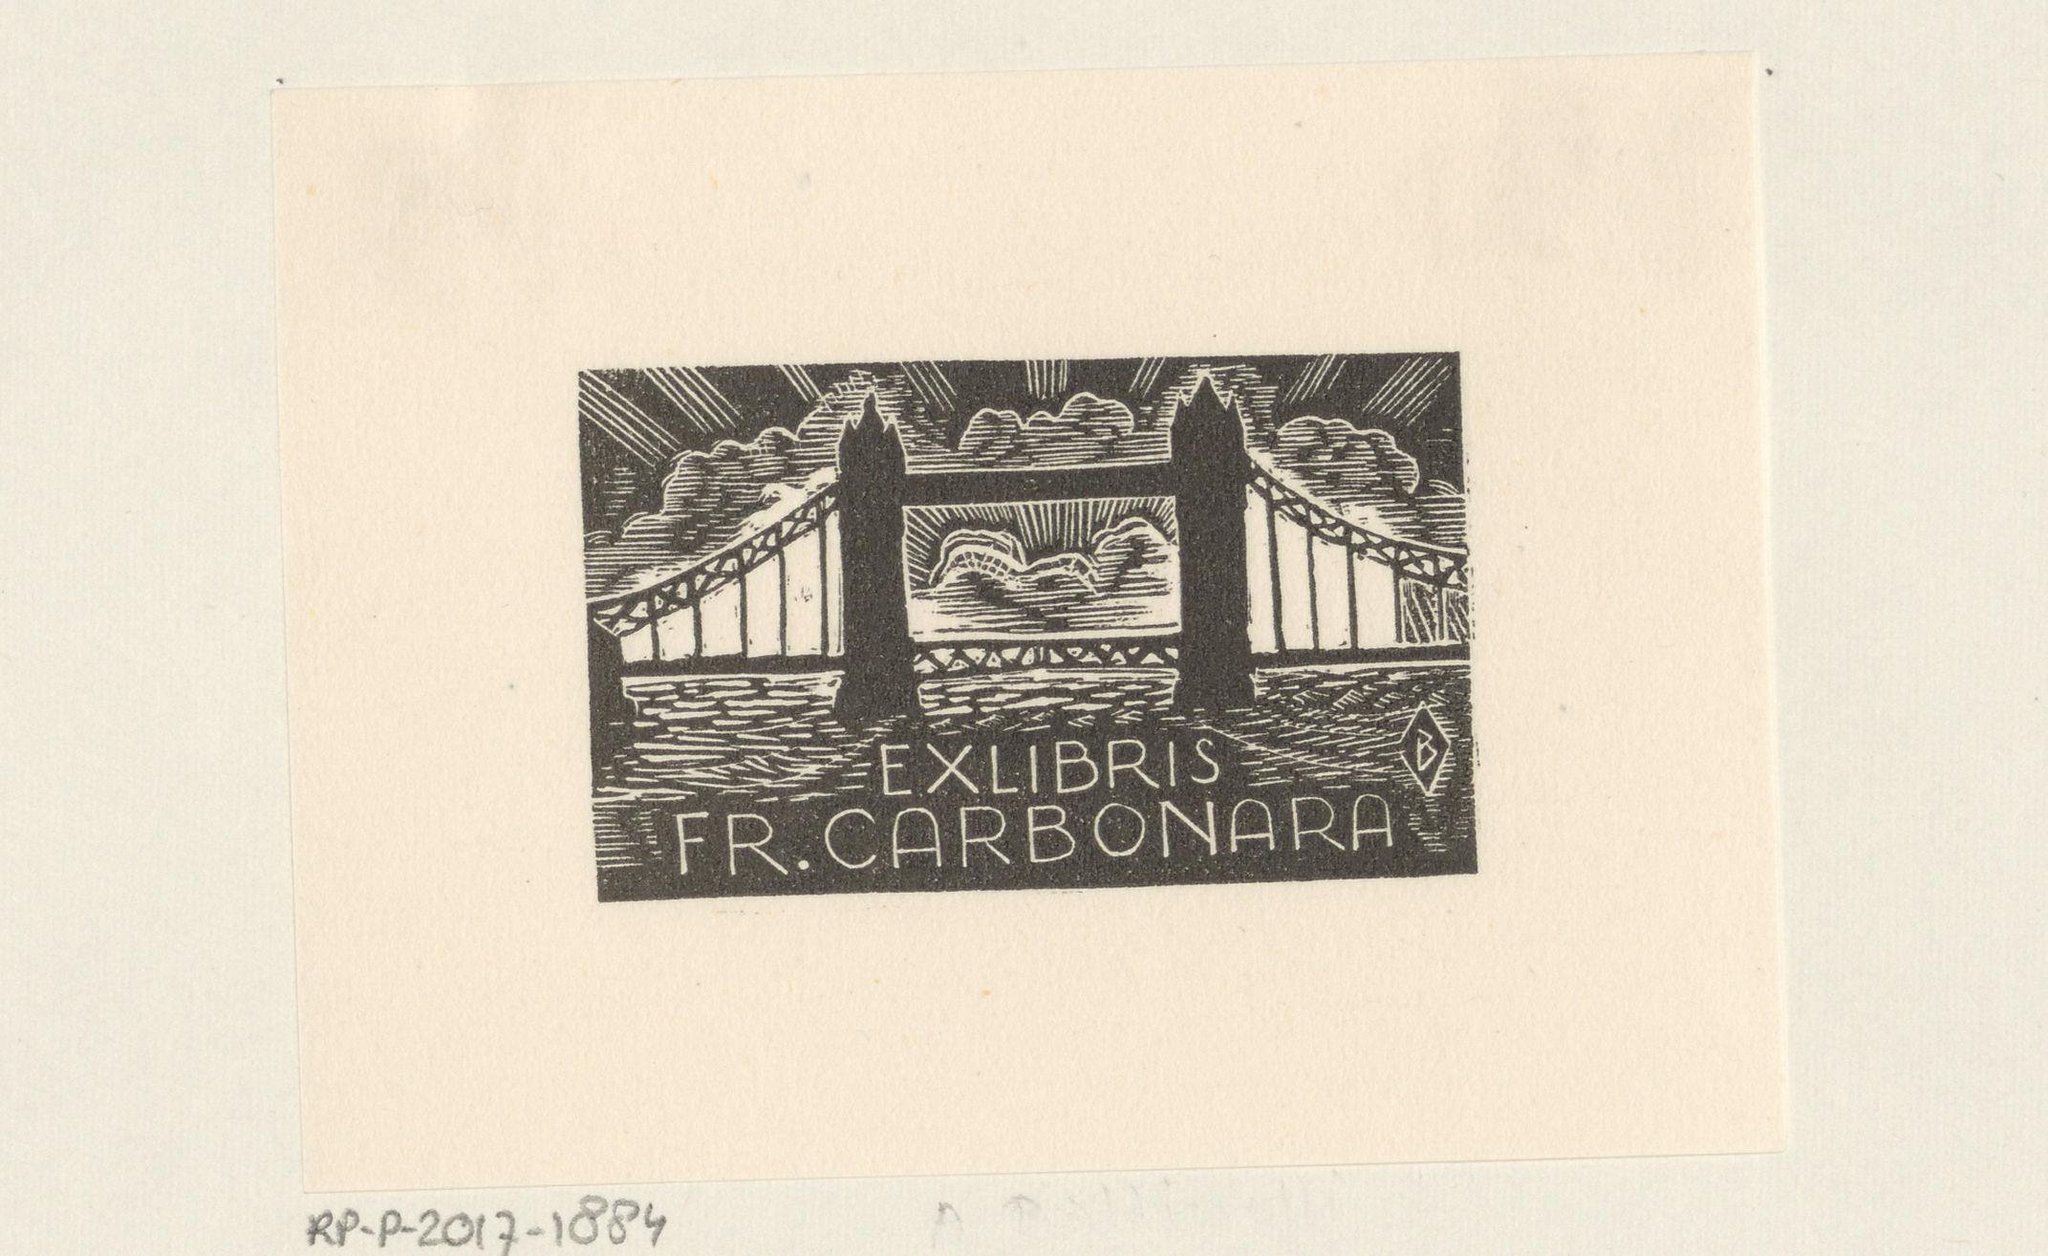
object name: bookplate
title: Ex libris van Fr. Carbonara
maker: theo broekstra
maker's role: print maker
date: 1949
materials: paper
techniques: engraving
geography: netherlands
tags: bridge, london